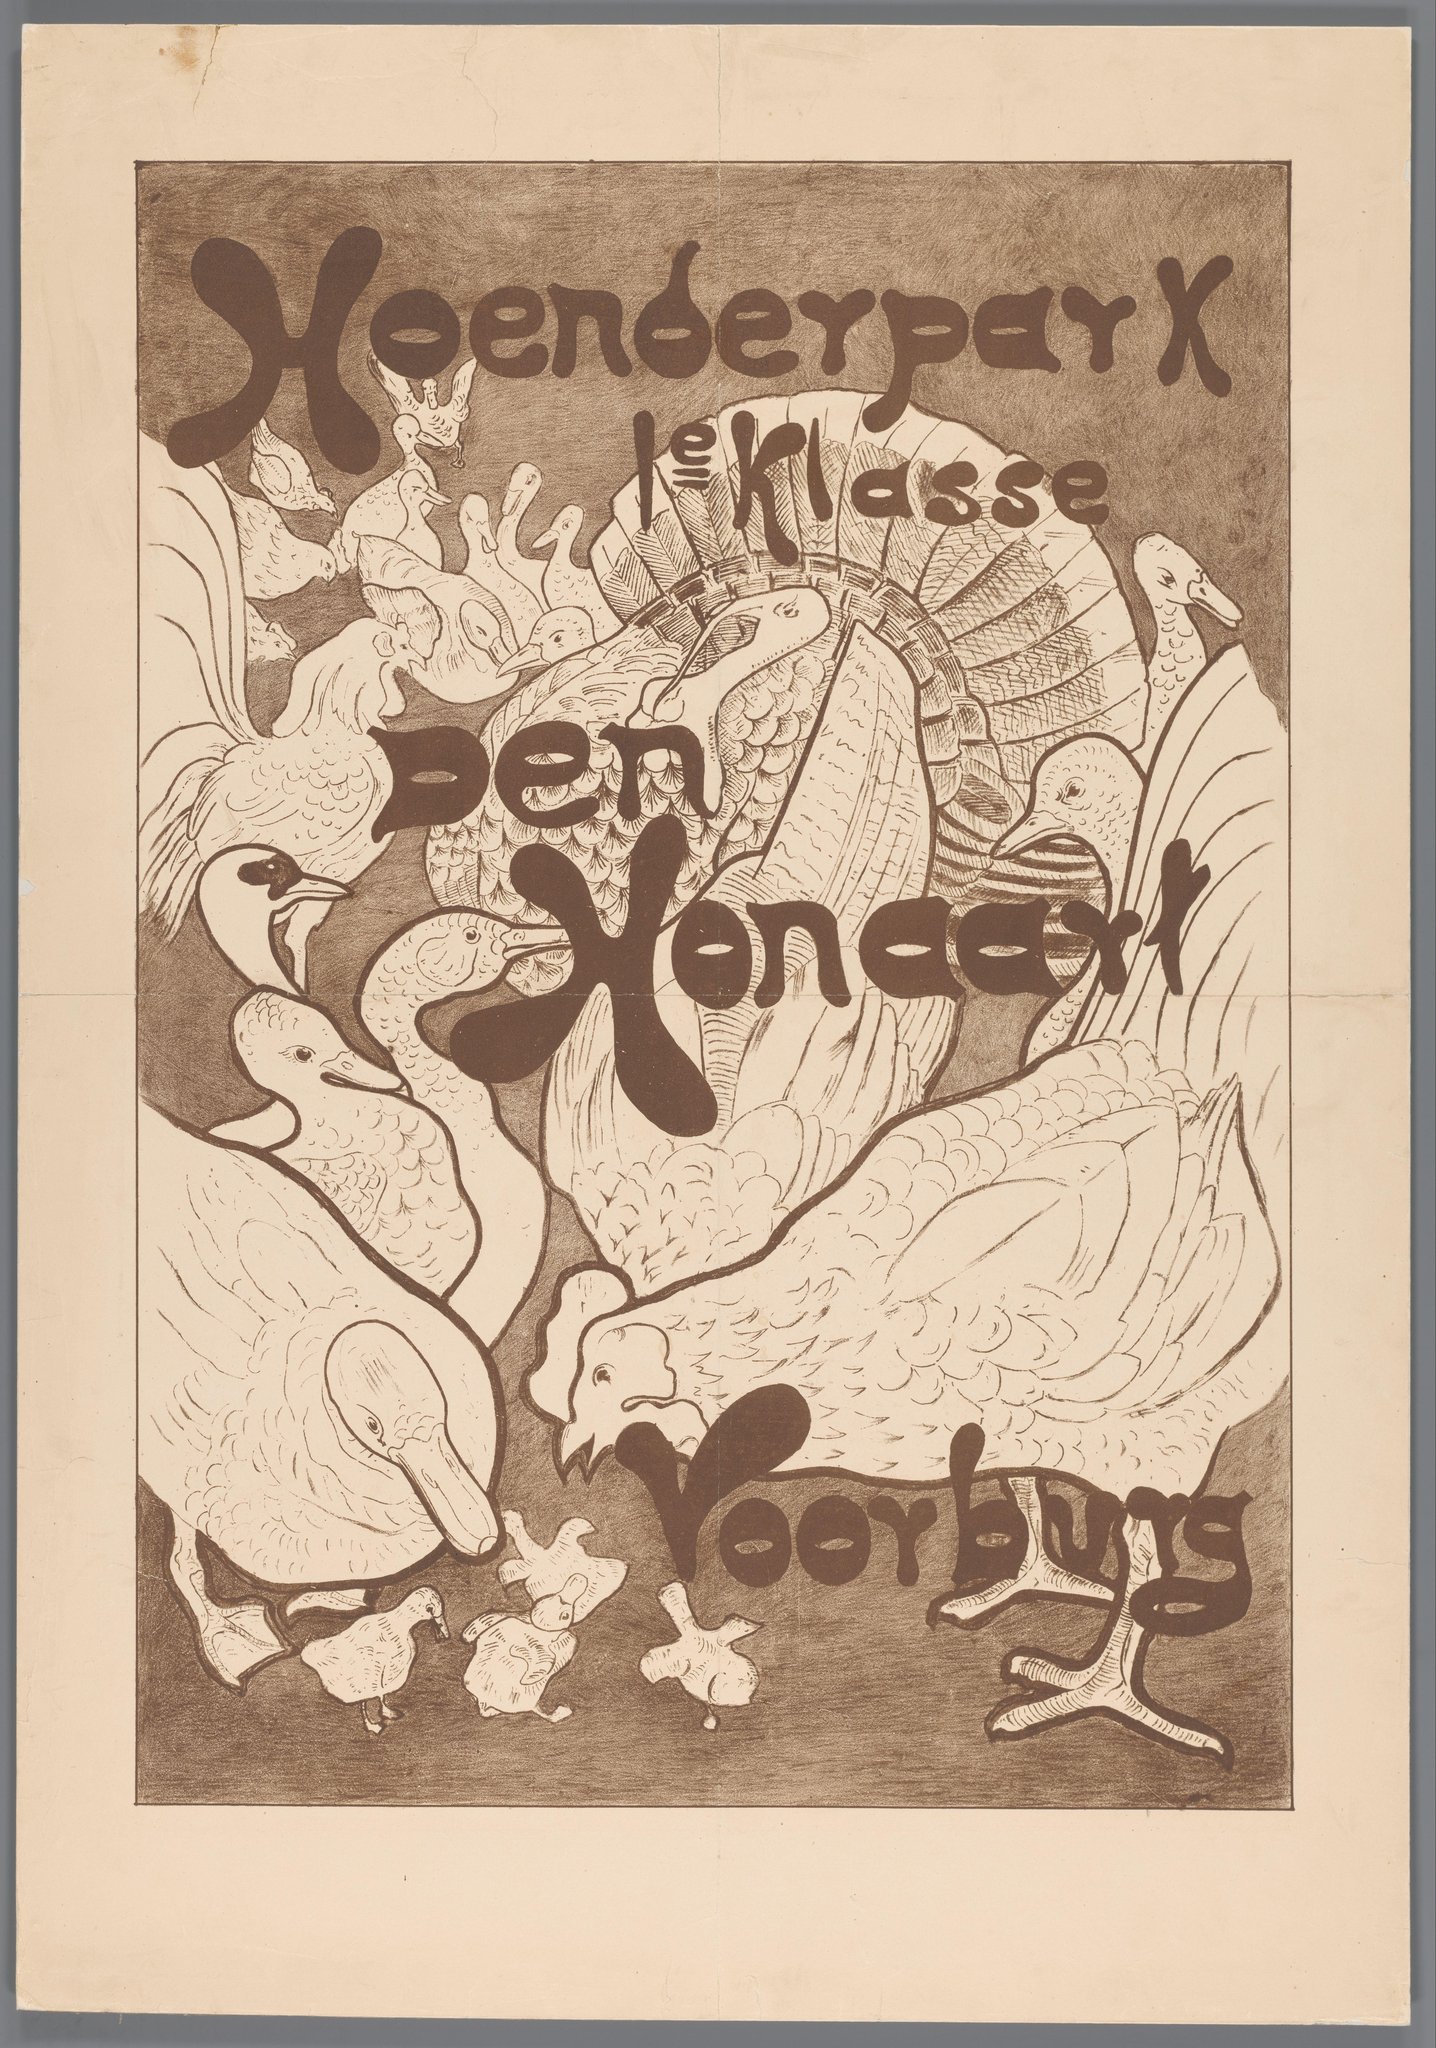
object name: poster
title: Affiche voor het Hoenderpark 1e klasse Den Honaart Voorburg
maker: theo van hoytema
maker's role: draughtsman, painter, print maker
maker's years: 1863-1917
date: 1873-1917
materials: cardboard, paper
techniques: lithograph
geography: netherlands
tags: fowl (cock, hen, chicken, etc.), poster, water-birds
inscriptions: collector's mark: Lugt 2760, collector's mark: Lugt 2228